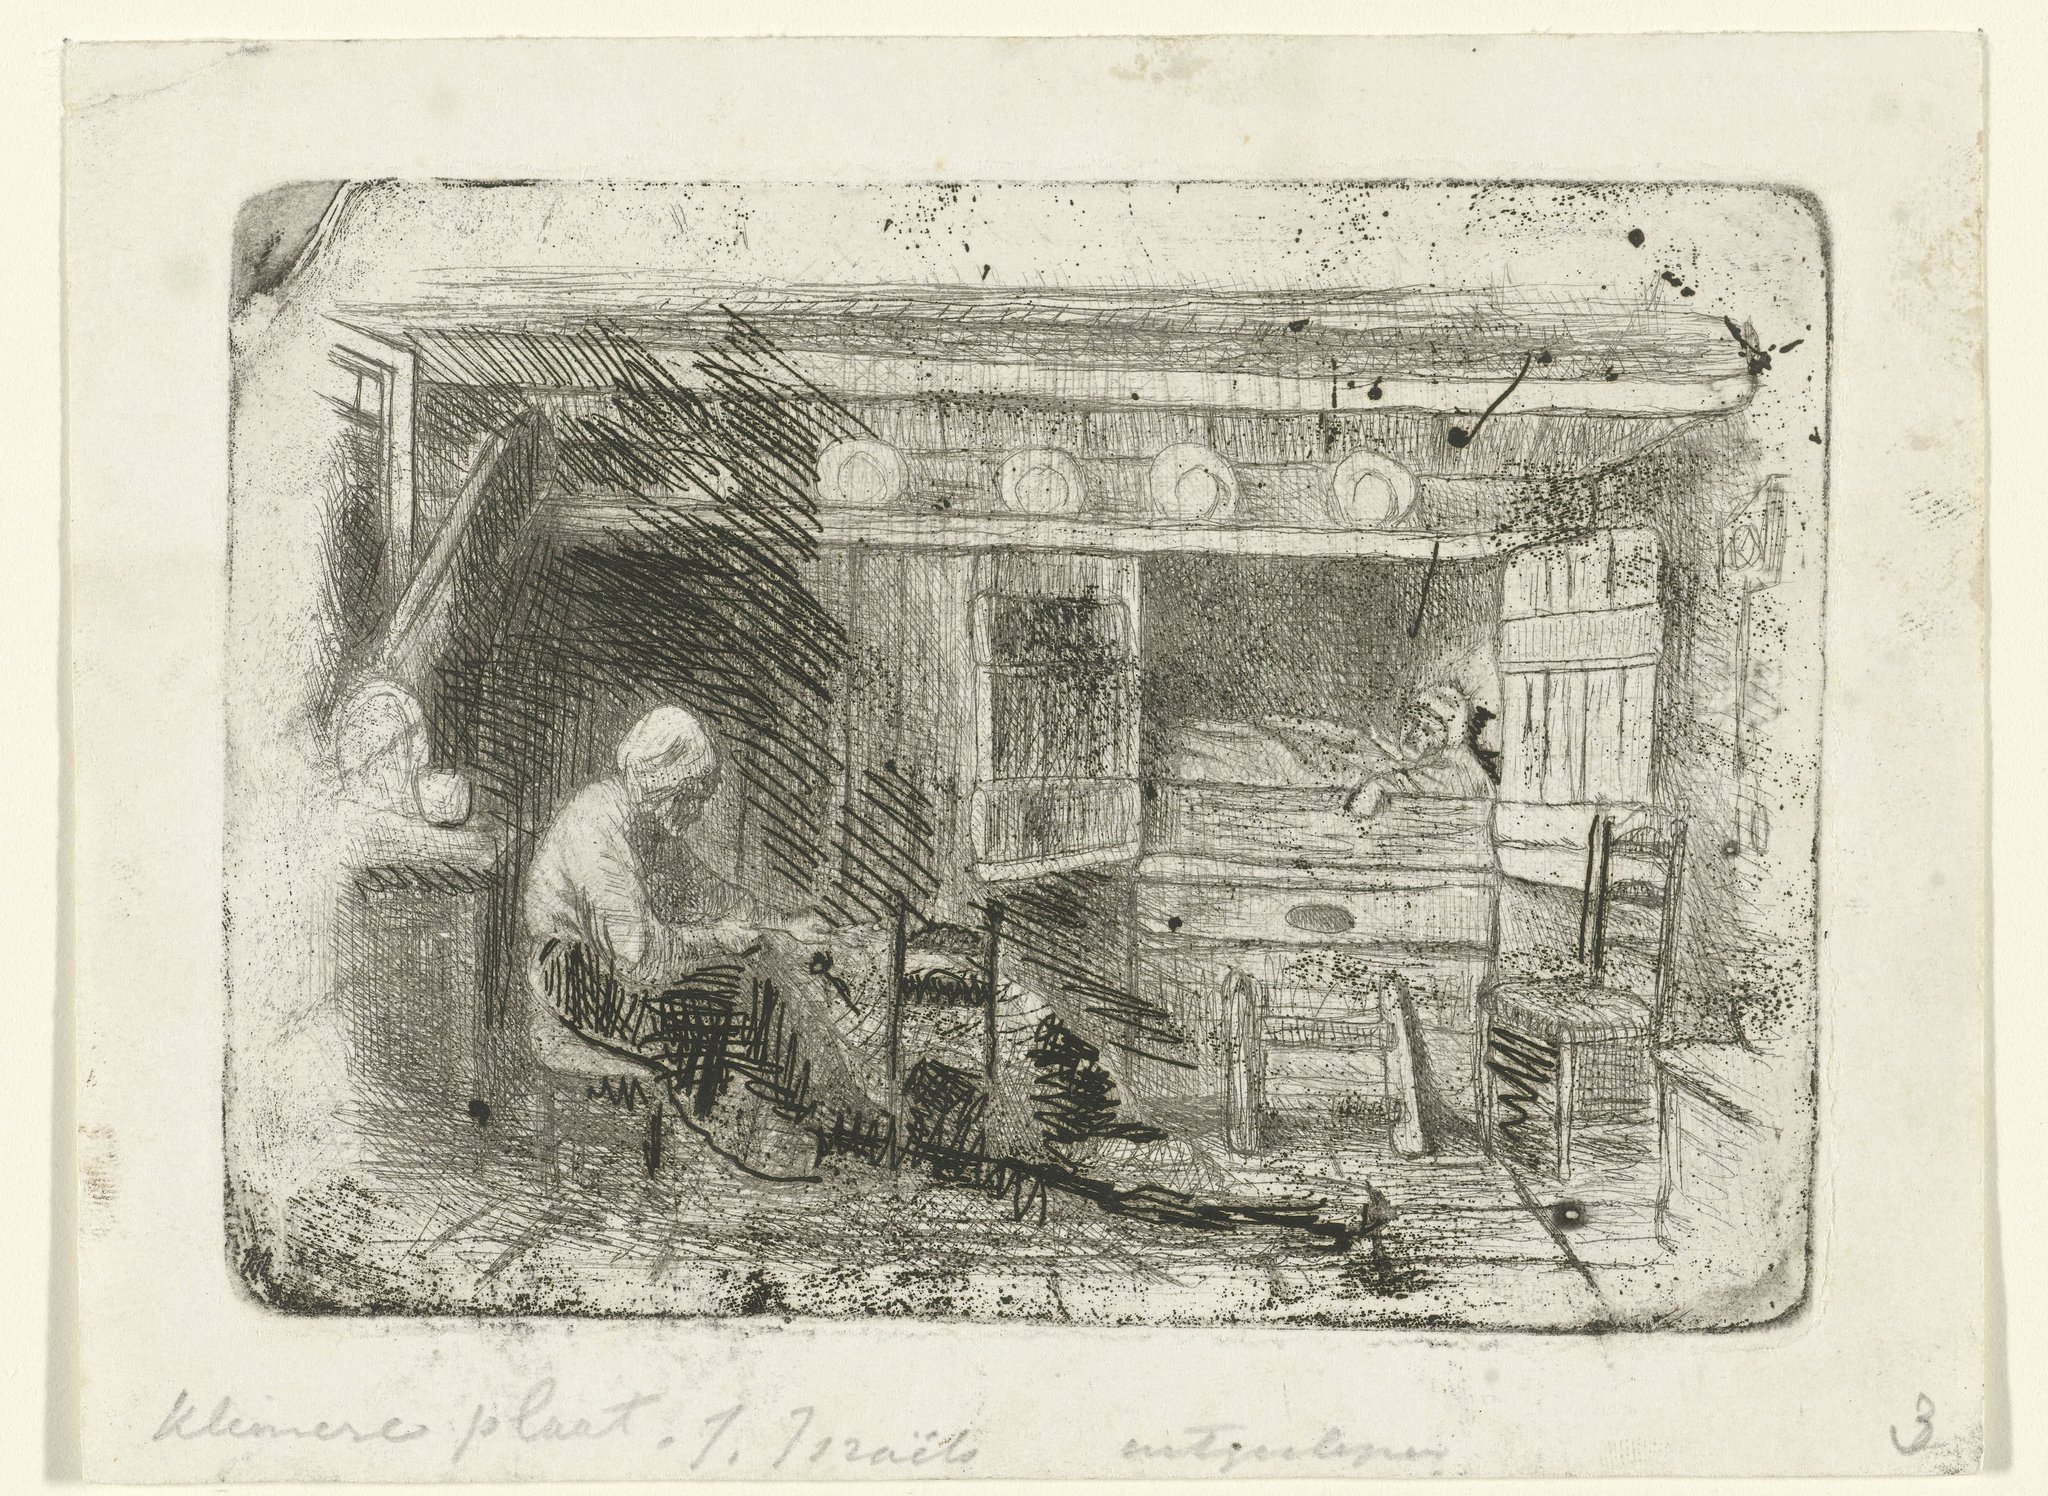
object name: print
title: Twee figuren in een interieur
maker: jozef israëls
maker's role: draughtsman, painter, print maker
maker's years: 1824-1911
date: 1835-1888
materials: ink, paper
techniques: etching, pen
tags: adult woman, interior of the house, (other forms of) needlework, e.g.: crocheting, knitting, embroidering, built-in bedstead (dutch: 'bedstee')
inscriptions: collector's mark: Lugt 2228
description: Links een vrouw zittend op een stoel in een interieur. Zij verstelt netten. In de bedstee ligt een oude man. Boven de bedstee hangen vijf borden aan de muur.